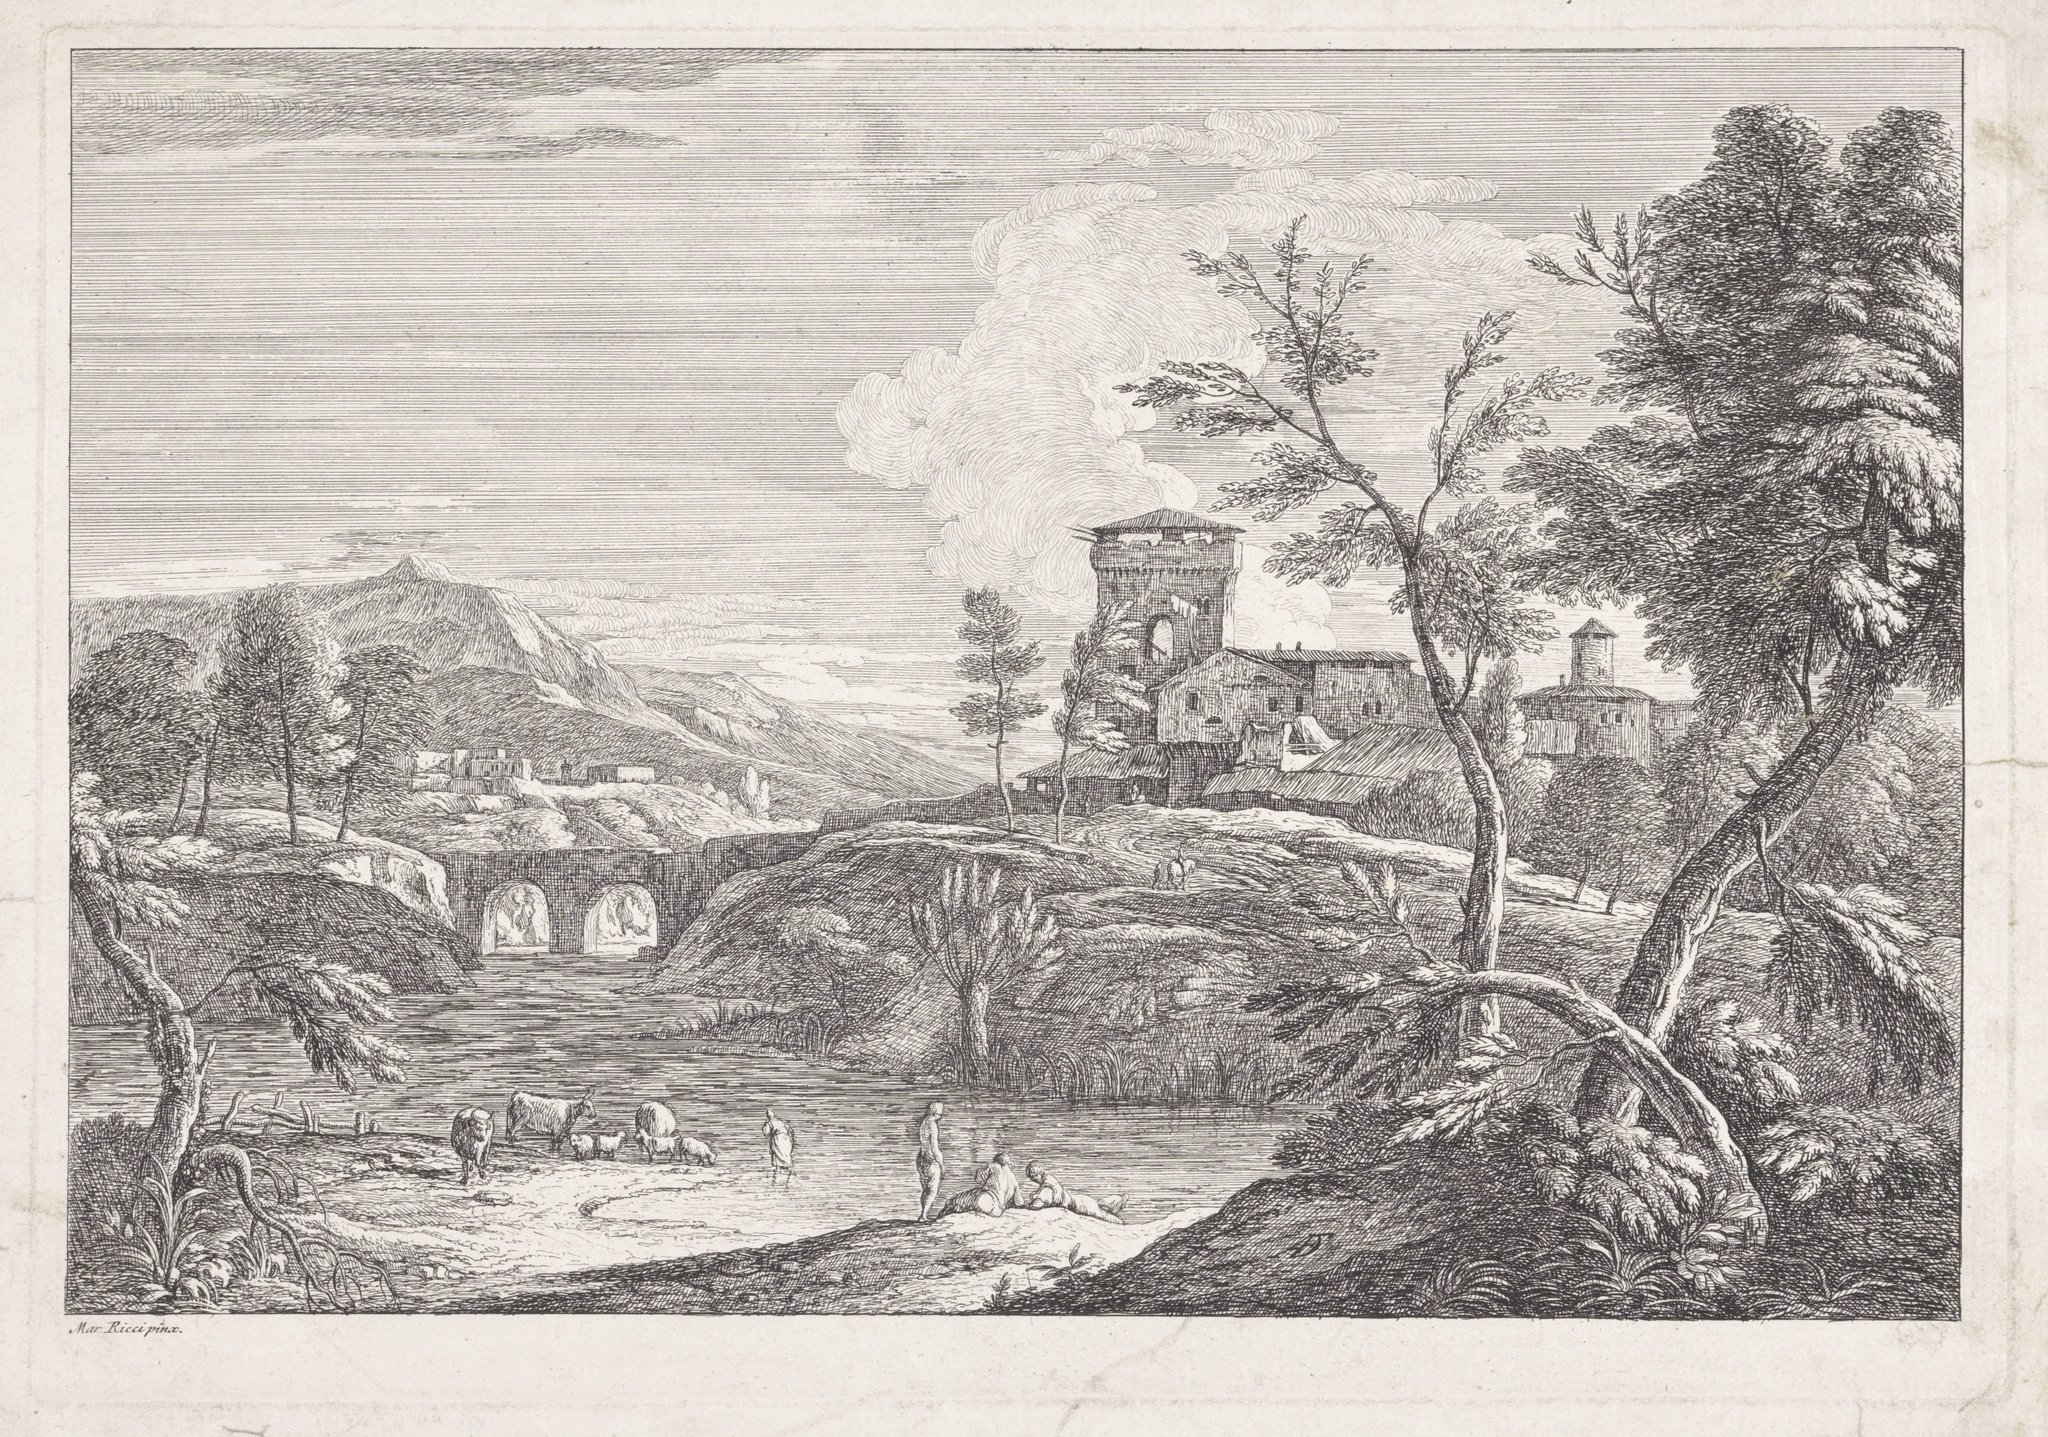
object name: print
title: Landschappen naar Marco Ricci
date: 1743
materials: paper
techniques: etching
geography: italy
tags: city-view, and landscape with man-made constructions, landscapes, river, herding, herdsman, herdswoman, shepherd, shepherdess, cowherd, etc., herd, flock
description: Rivierlandschap met kleine nederzettingen. Op de voorgrond een herder met zijn kudde aan de waterkant.